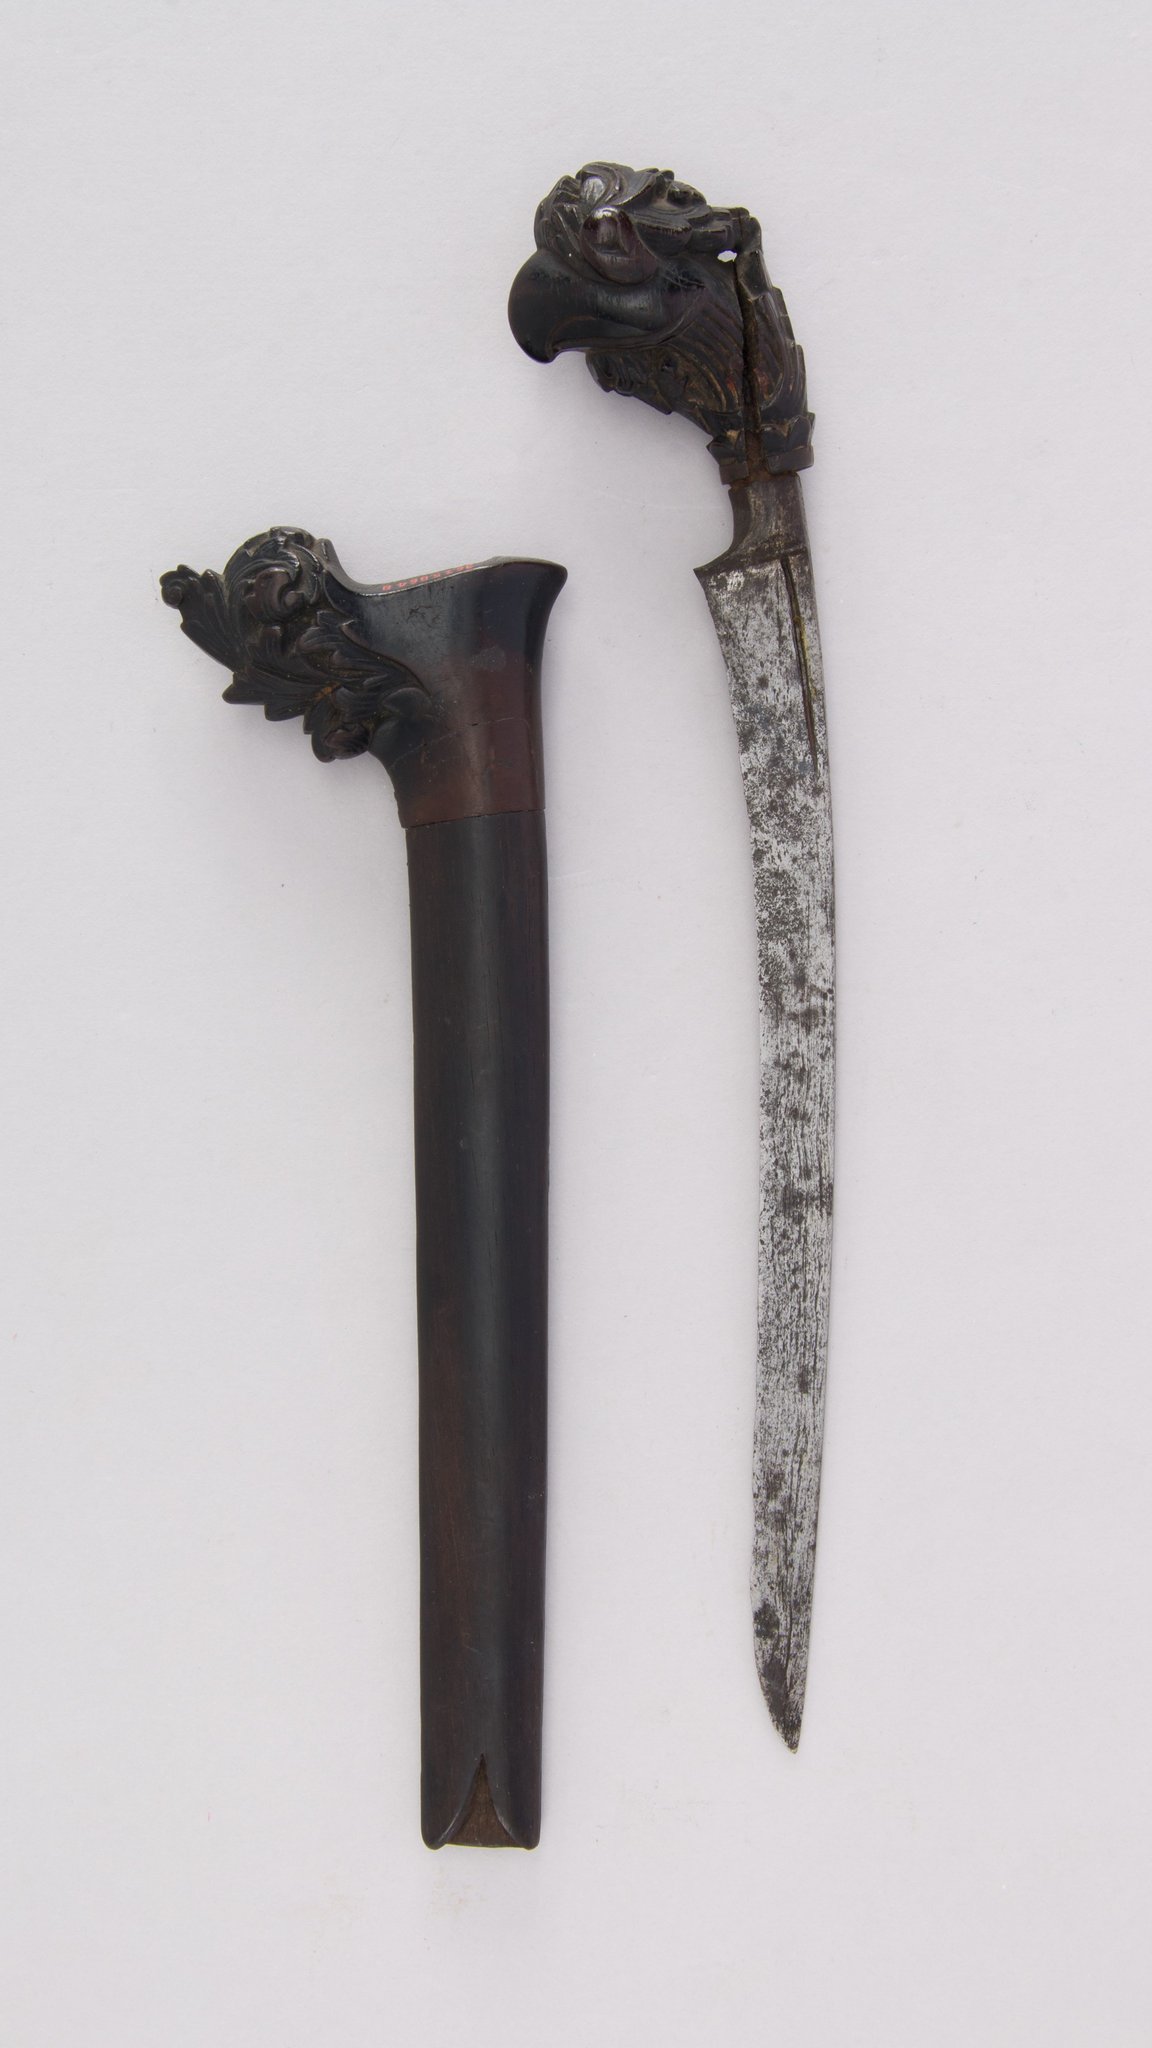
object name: knife bade bade with sheath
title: Knife (Bade-bade) with Sheath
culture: malayan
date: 1701-1900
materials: steel, wood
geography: malaysia